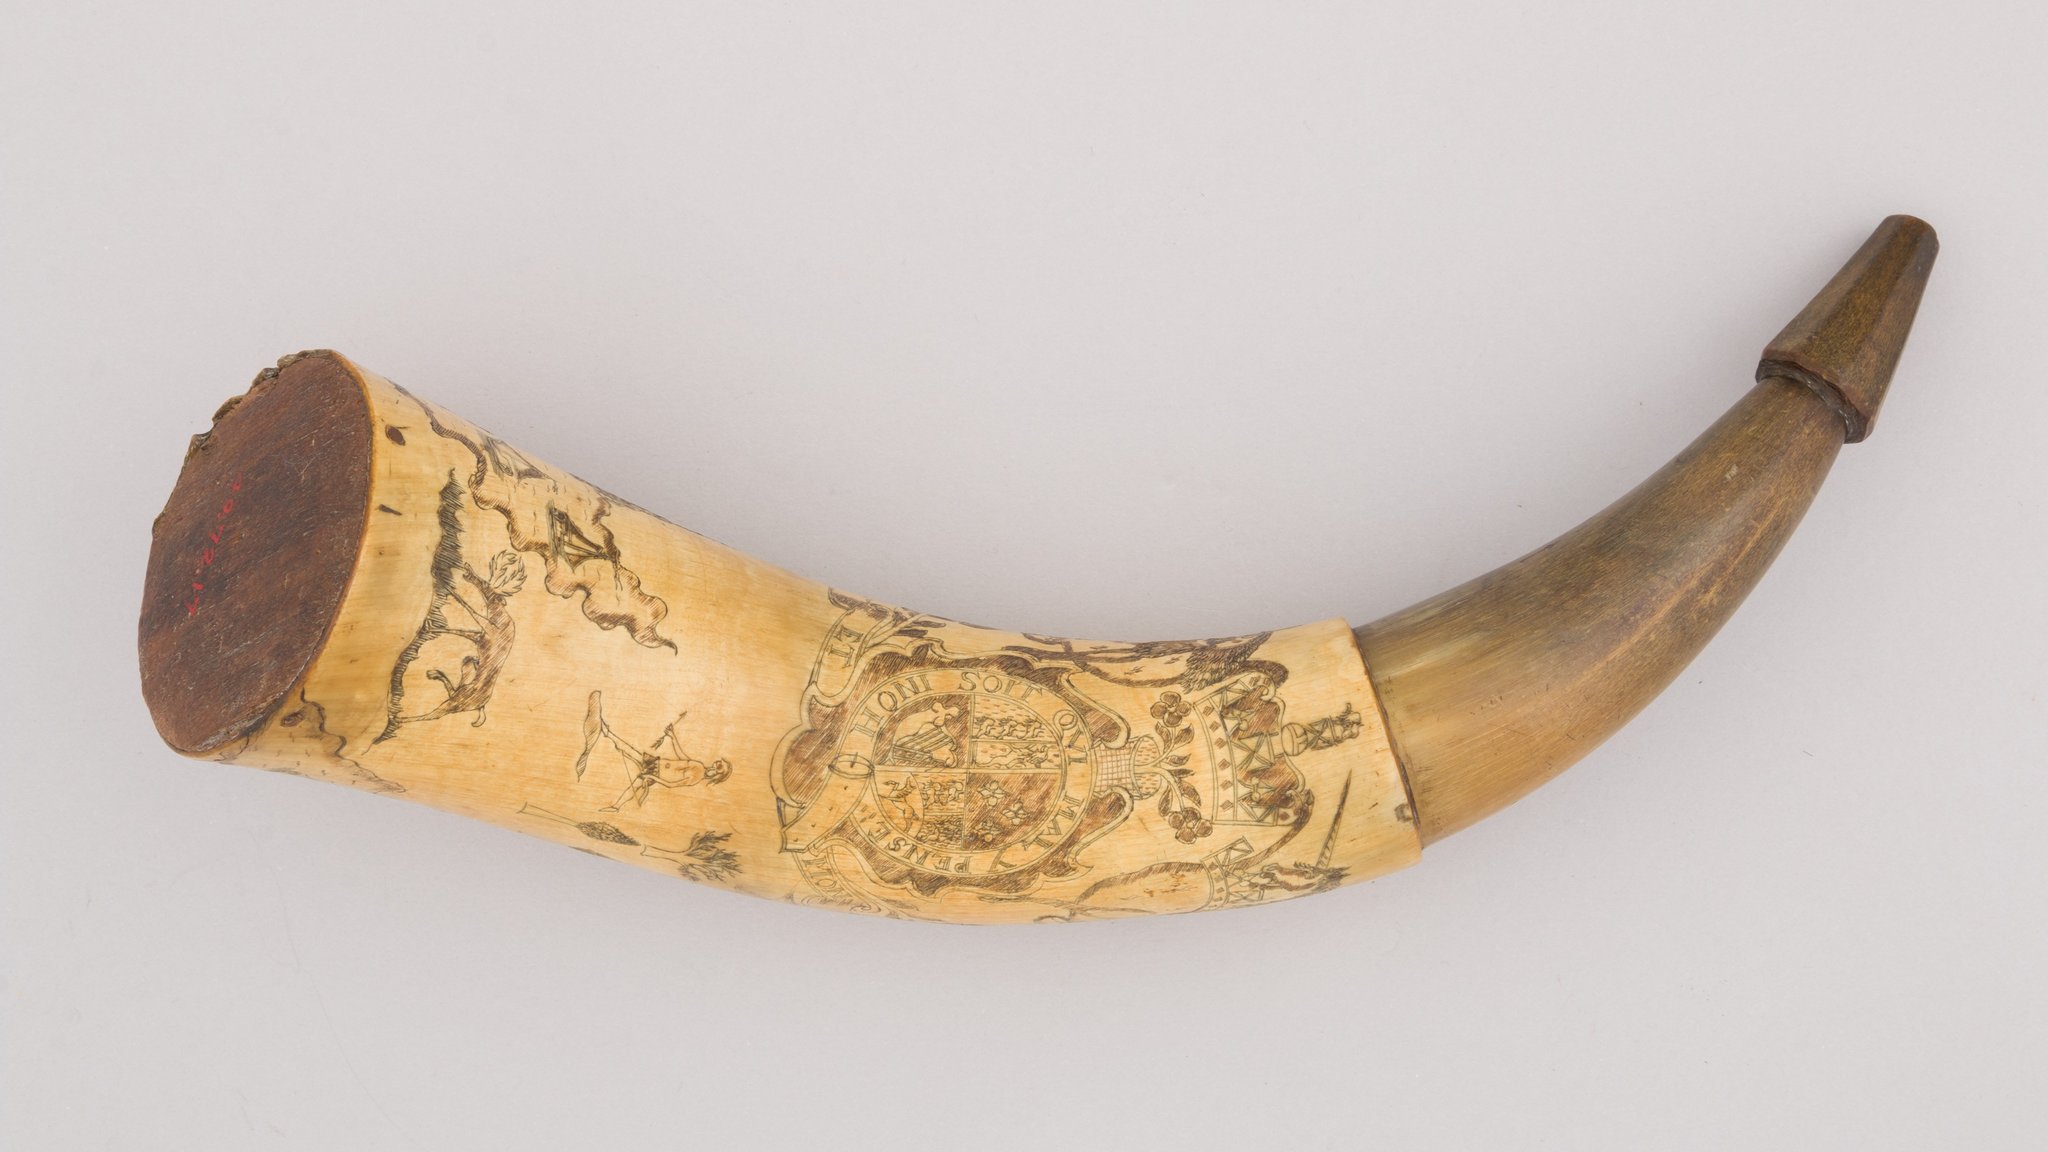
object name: powder horn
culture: american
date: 1701-1800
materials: horn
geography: united states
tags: cities,horses,coat of arms